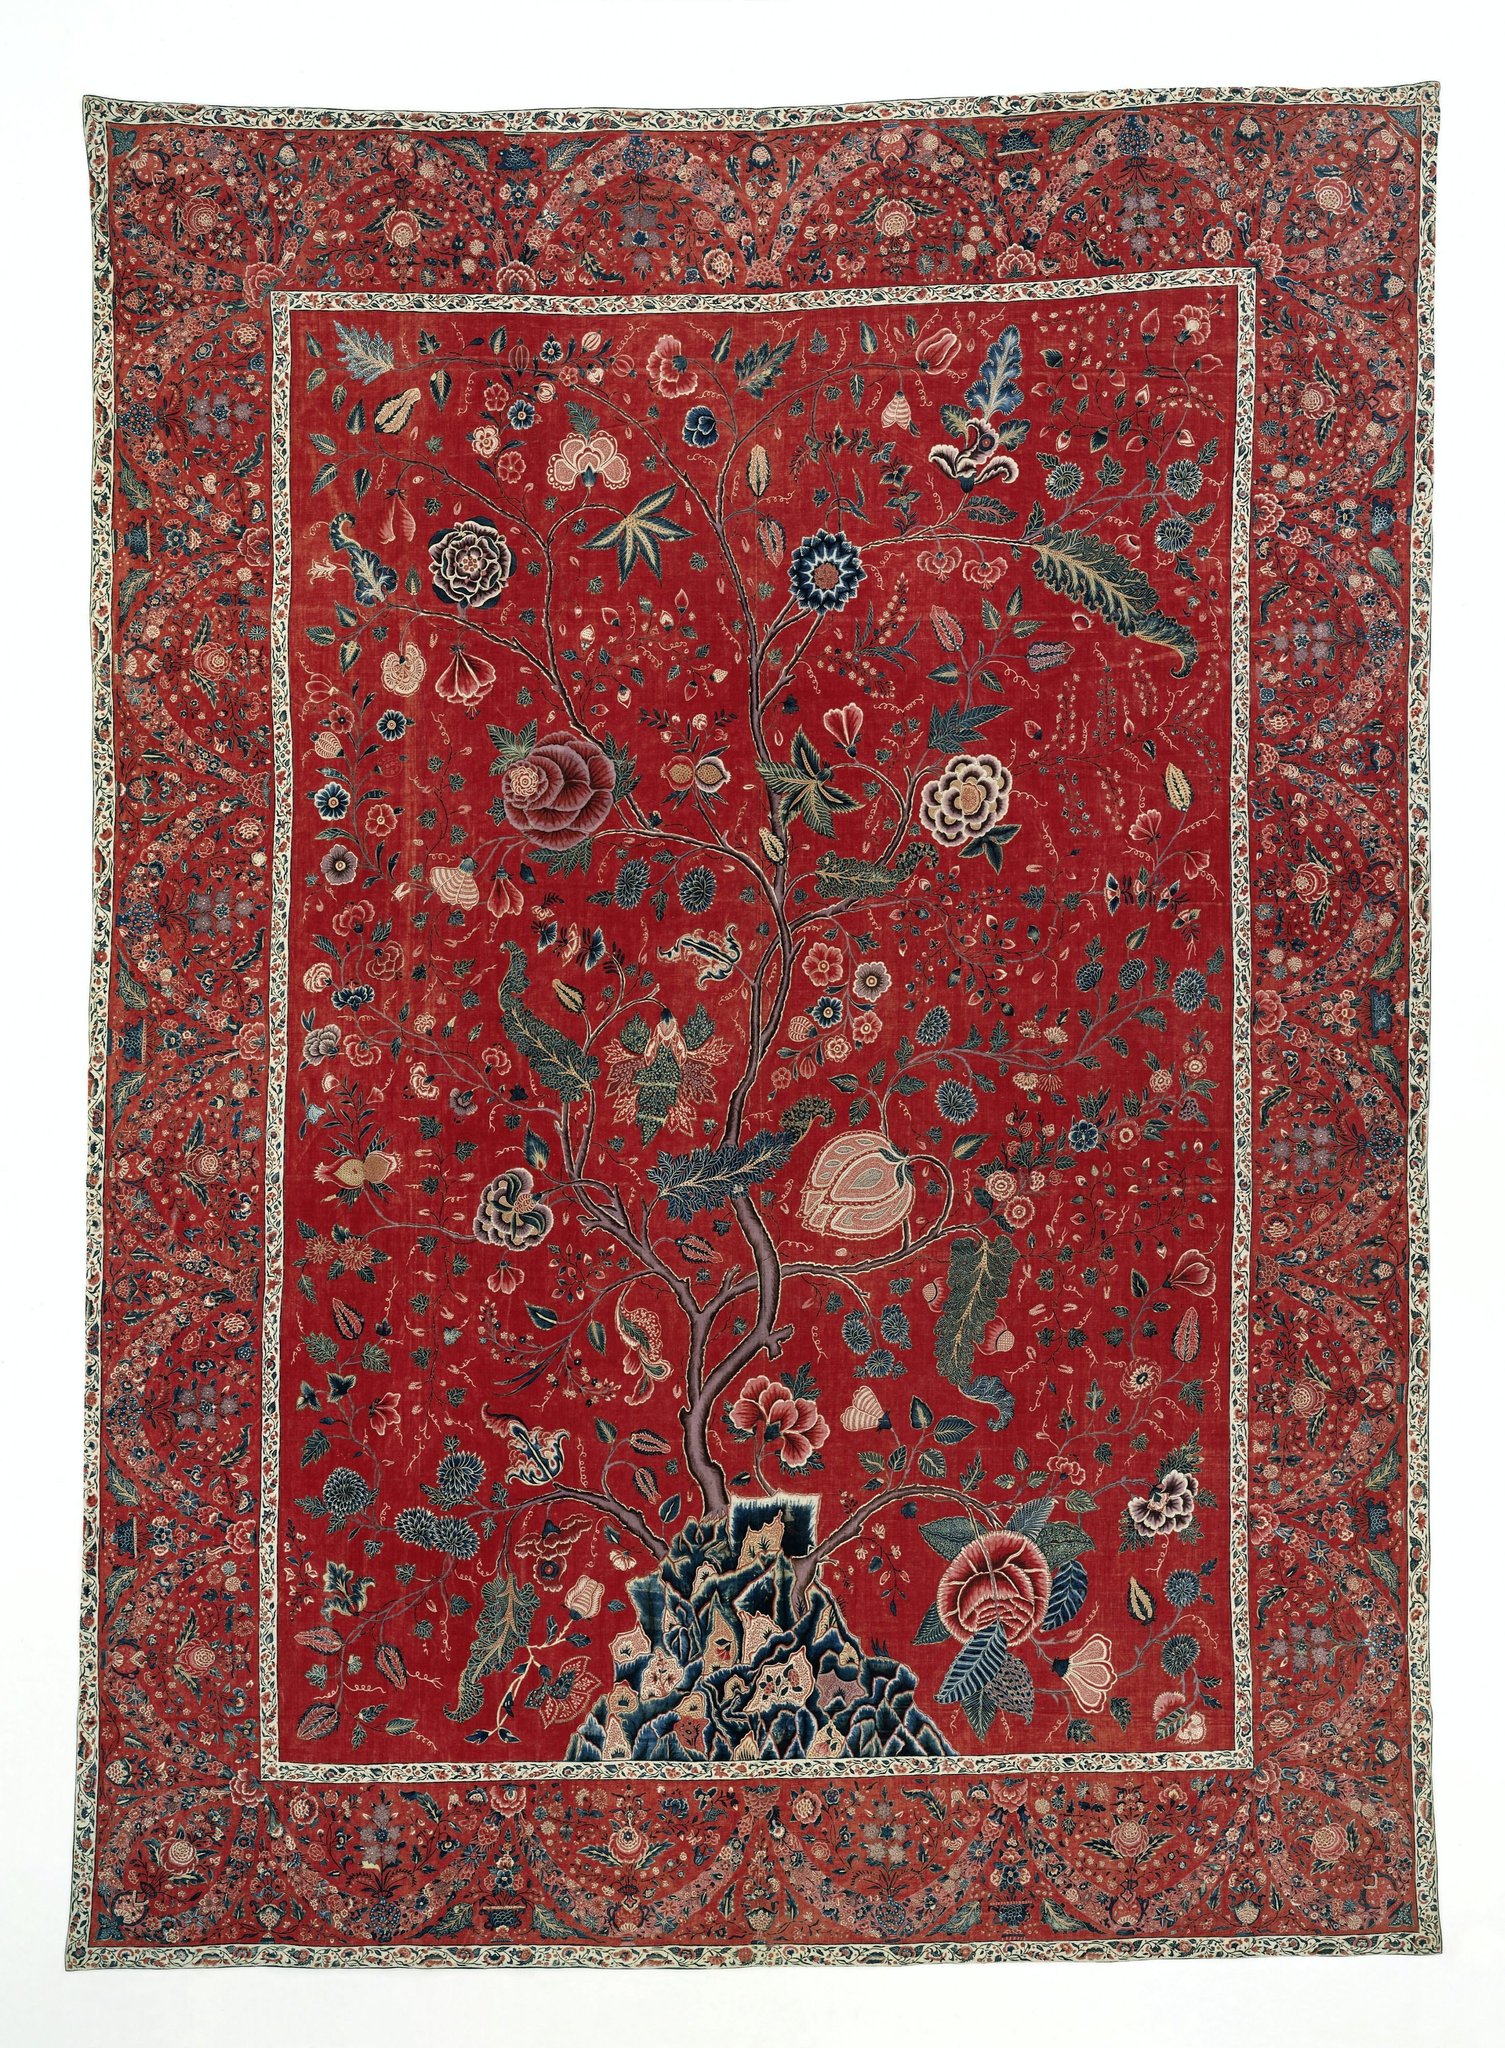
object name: bed covering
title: Palampore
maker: Anonymous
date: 1725-1750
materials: textile, cotton, linen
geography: india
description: This type of large cloth was usually thrown over a bed, stretched behind it, or hung throughout the room. It was known in Europe as a ‘palampore’, a name derived from the Persian and Hindi (India’s official language) ‘palangposh’. This cloth is decorated with the floweringtree motif.